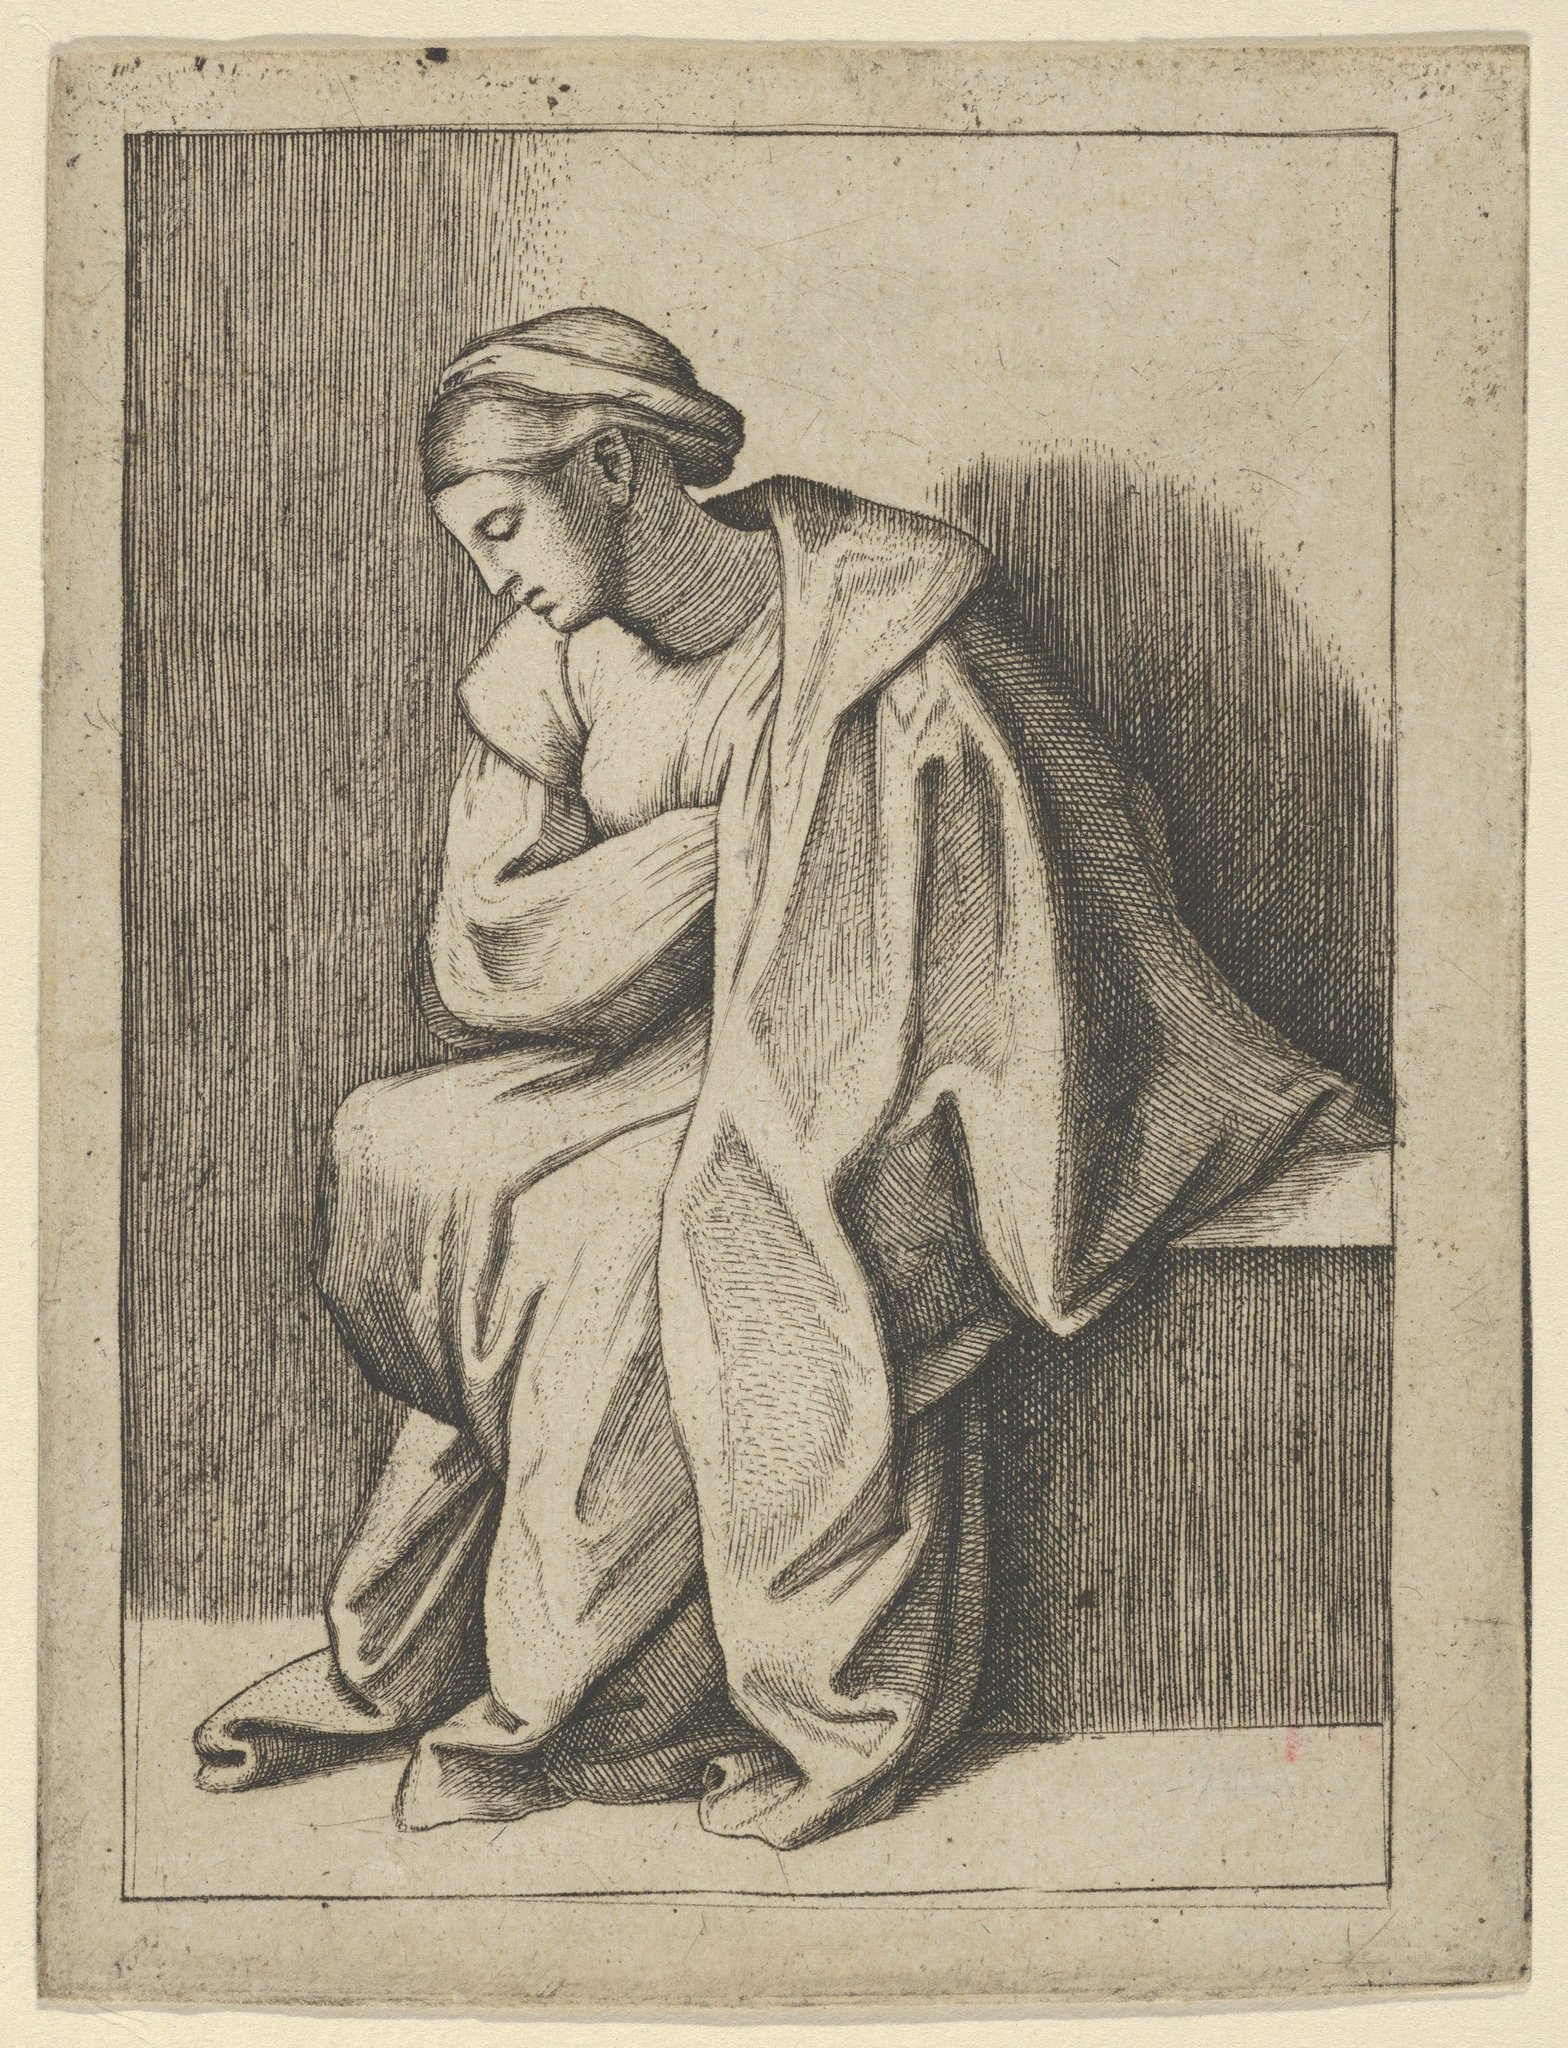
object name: print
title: Woman sitting with her head turned downward to her right and eyes closed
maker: Anonymous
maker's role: artist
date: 1500-1550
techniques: engraving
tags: women